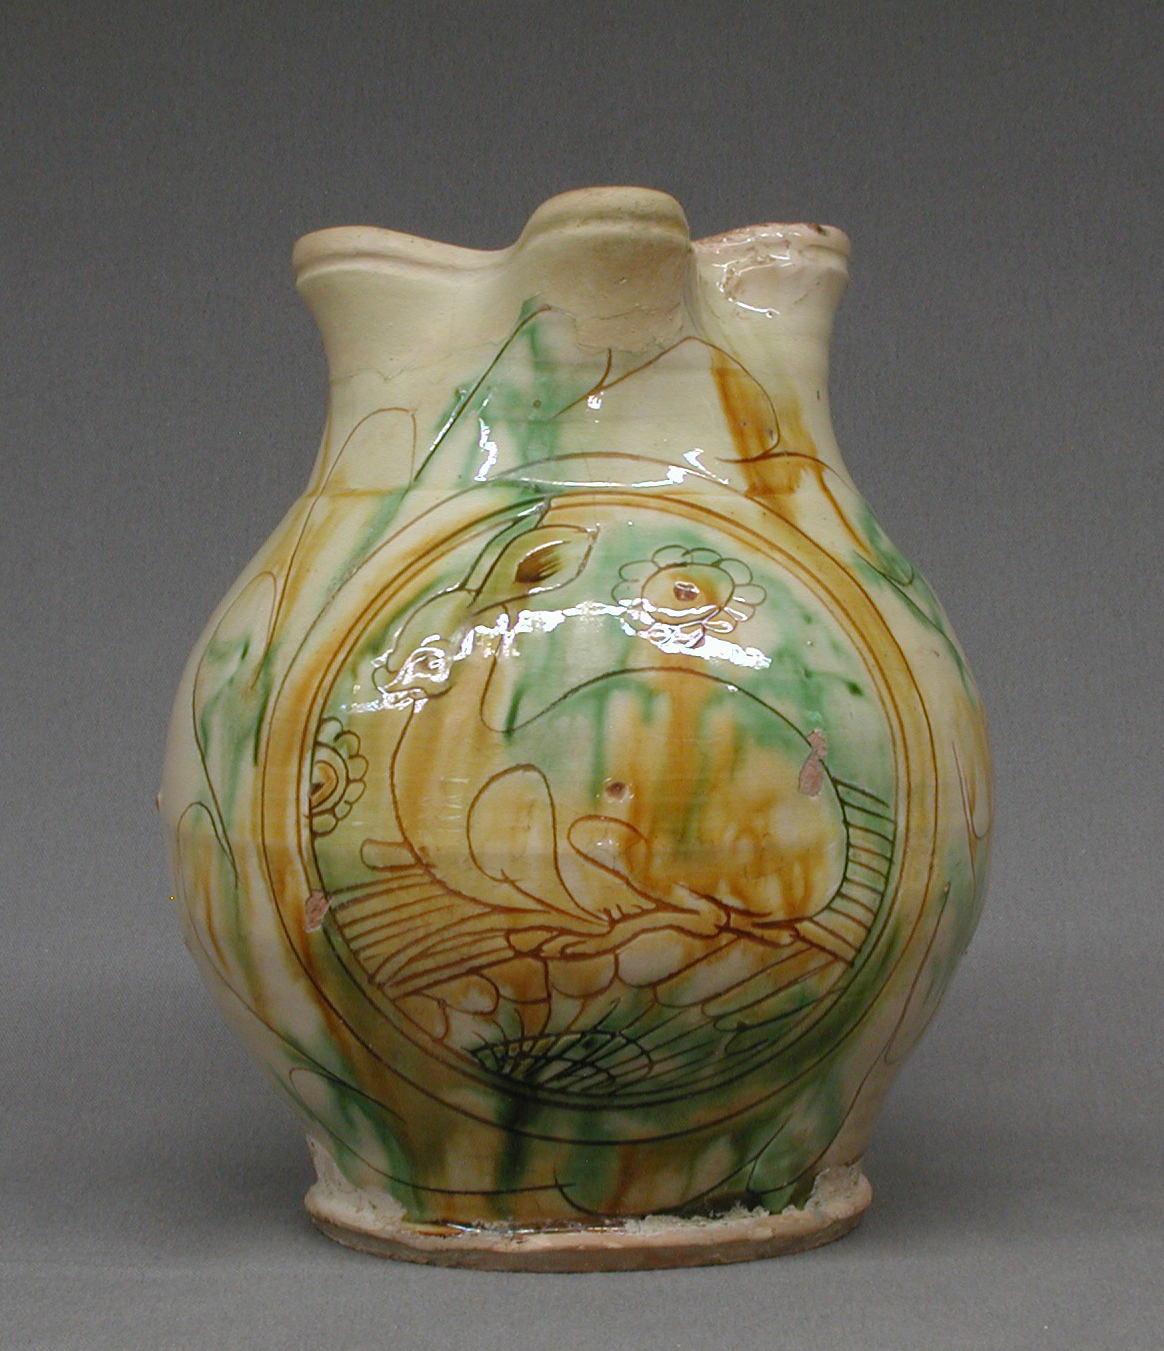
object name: jug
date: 1501-1600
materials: earthenware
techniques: glazing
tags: deer,flowers